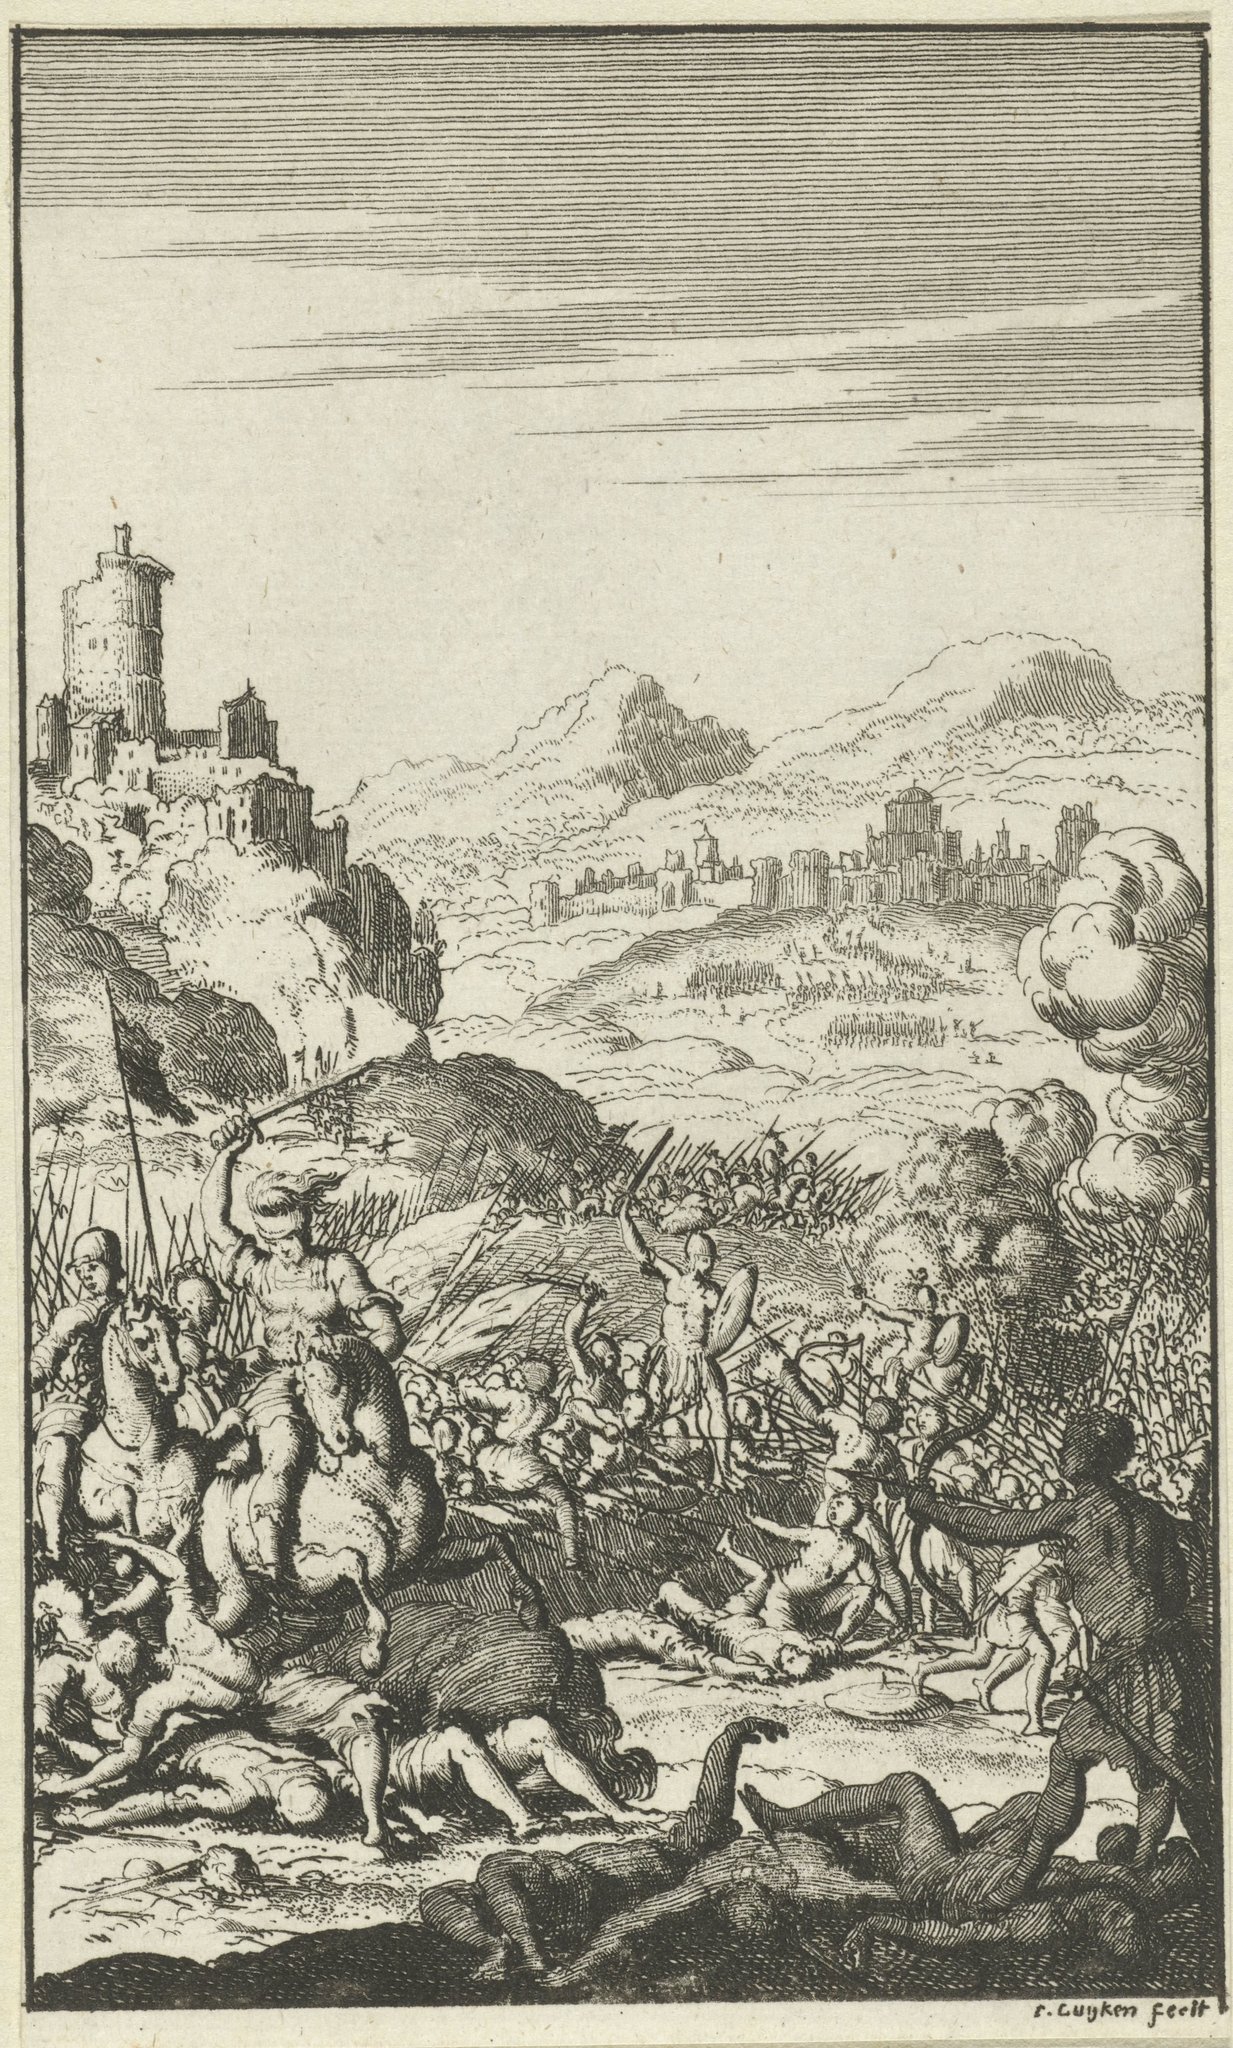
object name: book illustration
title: Strijd tussen de legers van Poliarchus en Ambiodorix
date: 1681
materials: paper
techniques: etching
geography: amsterdam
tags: battle (+ land forces)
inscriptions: collector's mark: Lugt 240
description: Illustratie opgenomen in het tweede deel van: Barclay, John. D'Argenis, 2 delen. Amsterdam: Jan Claesz ten Hoorn, 1680-1681.